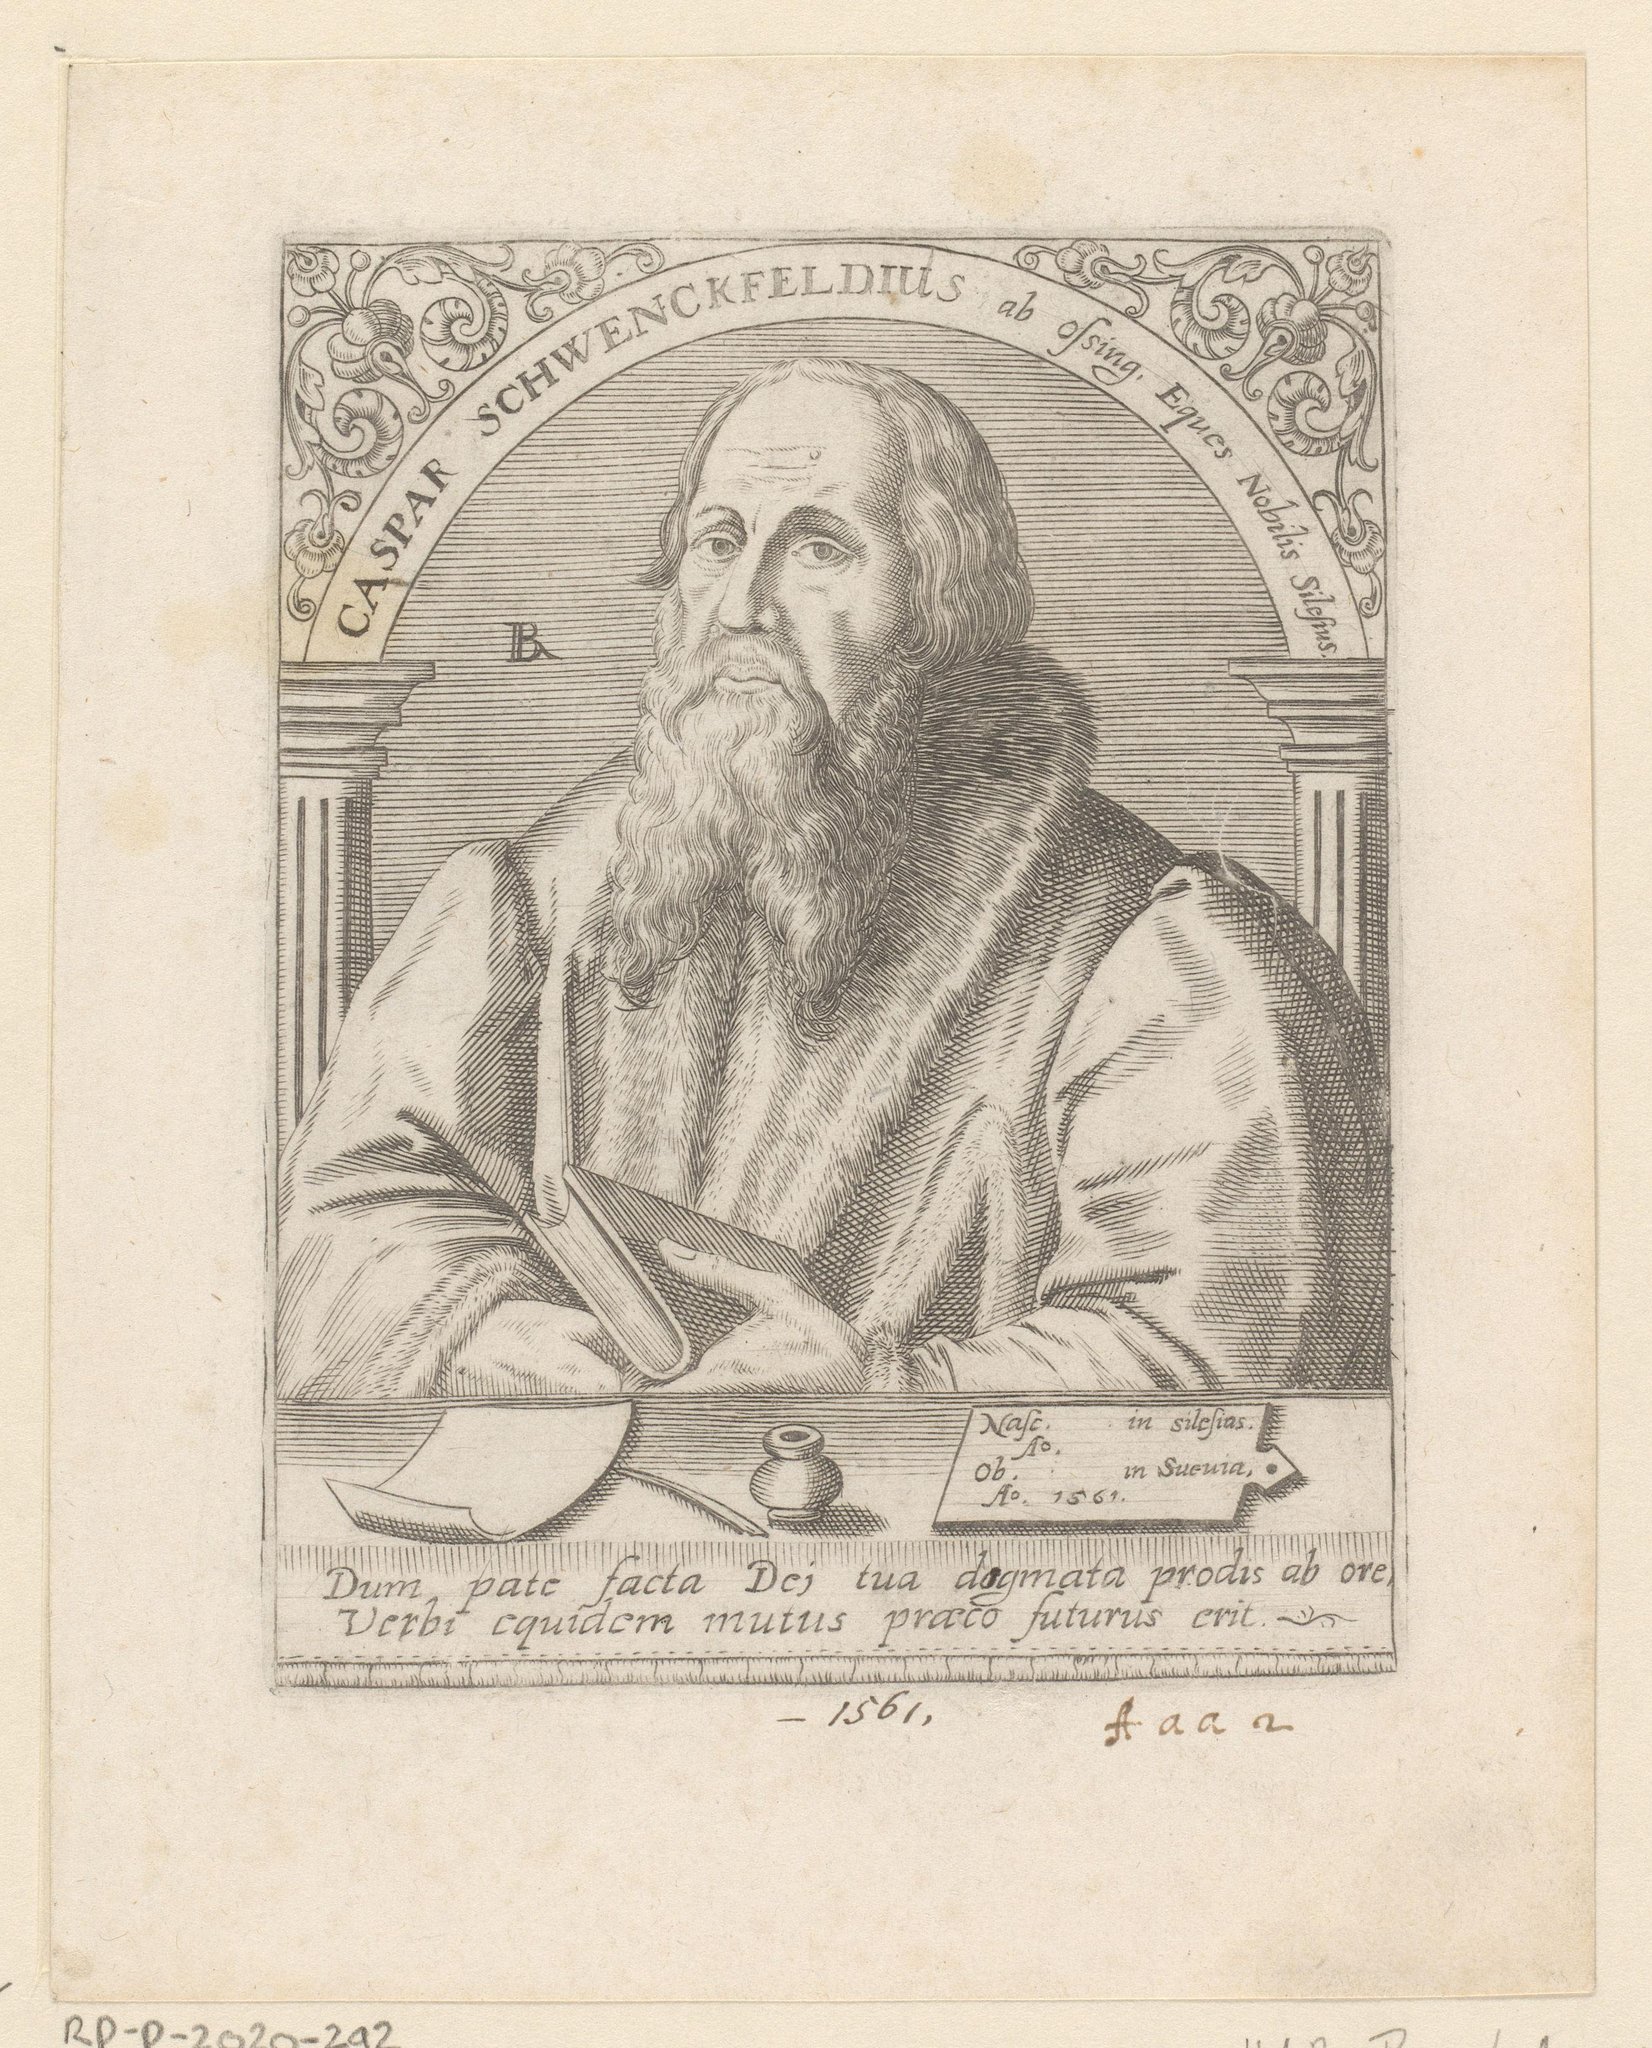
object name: print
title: Portret van Caspar Schwenckfeld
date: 1599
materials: paper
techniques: engraving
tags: theologian, historical persons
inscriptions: inscription: ‘-1561,’, inscription: ‘Aaa2’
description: Prent gebruikt in: Boissard, Jean Jacques. Icones quinquaginta virorum illustrium doctrina & eruditione praestantium ad vivum effictae. 4 dln. Frankfurt am Main: s.n., 1597-1599. Mogelijk ook gebruikt in latere edities. Latere staat van prent verschenen in: Boissard, Jean Jacques. Bibliotheca chalcographica. 8 dln. Frankfurt am Main: Johannes Ammon, 1650-1652. Ook gebruikt in latere edities.